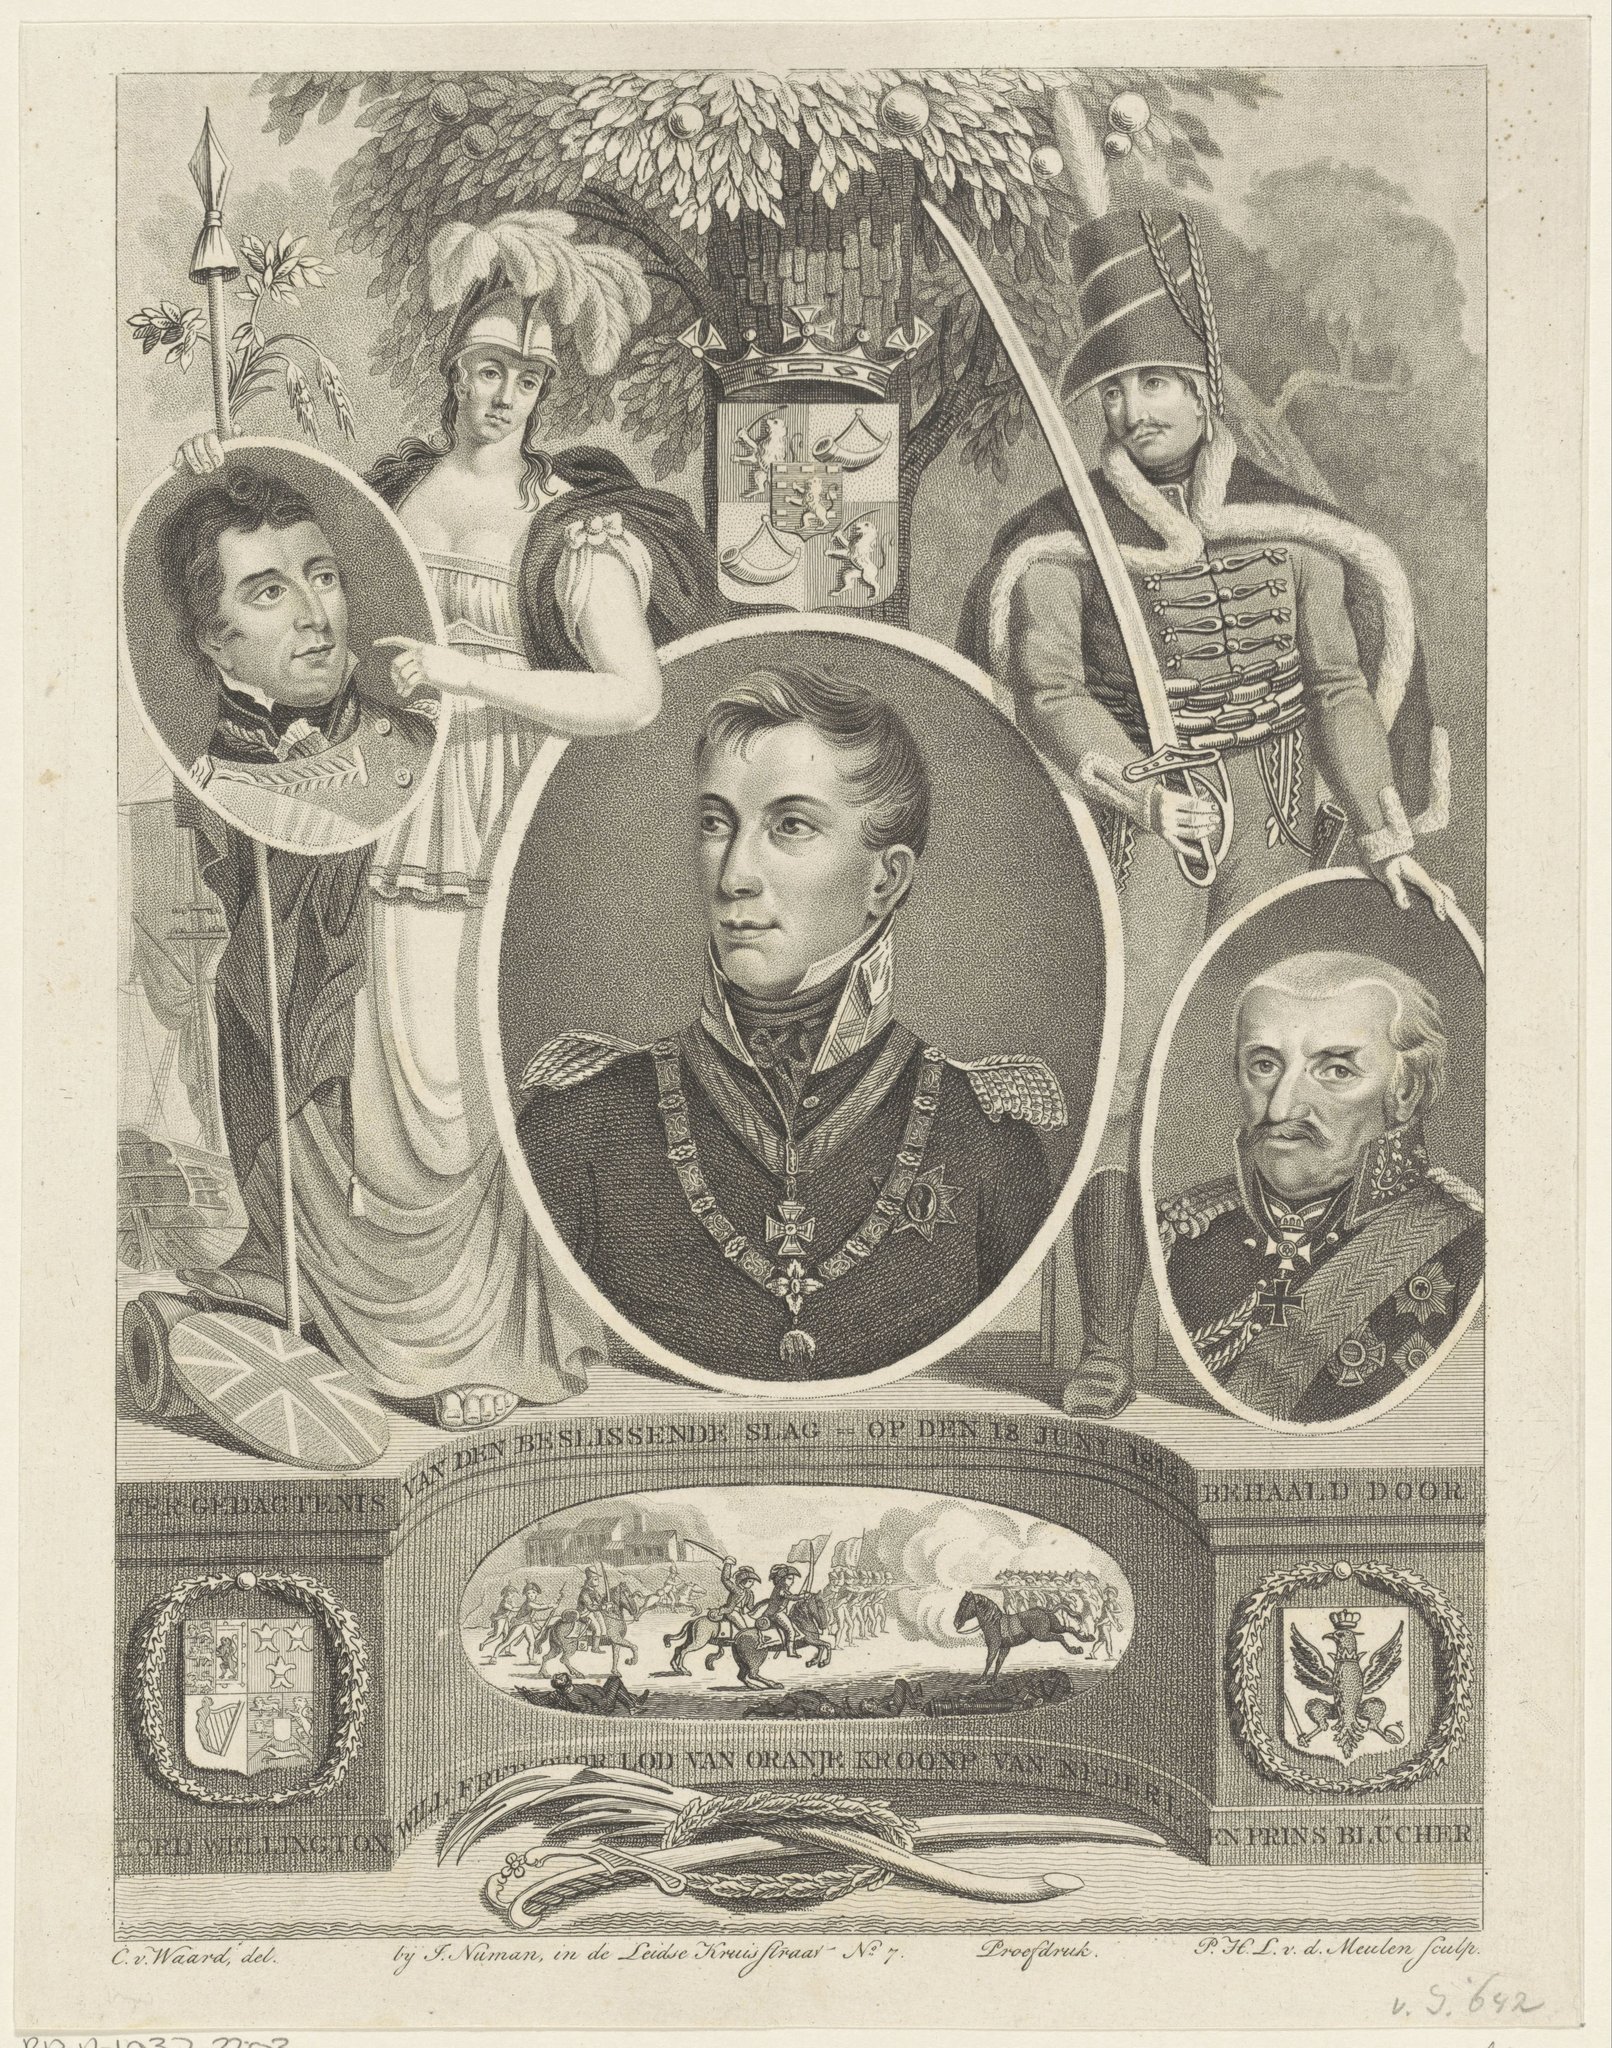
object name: print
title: Portret van Willem II, koning der Nederlanden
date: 1815-1826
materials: paper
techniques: engraving, etching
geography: amsterdam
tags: the hague, william ii of the netherlands, knighthood order of the golden fleece - insignia of a knighthood order, e.g.: badge, chain (with name of order)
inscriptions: collector's mark: Lugt 2228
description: Portret van Willem II in een ovaal. Links en rechts portretten van twee legeraanvoerders, elk in een ovaal. Daar omheen een aantal allegorische objecten en twee allegorische figuren. In een kader een voorstelling van de Slag bij Waterloo, 18 juni 1815. Rechtsonder 'Proefdruk.'.